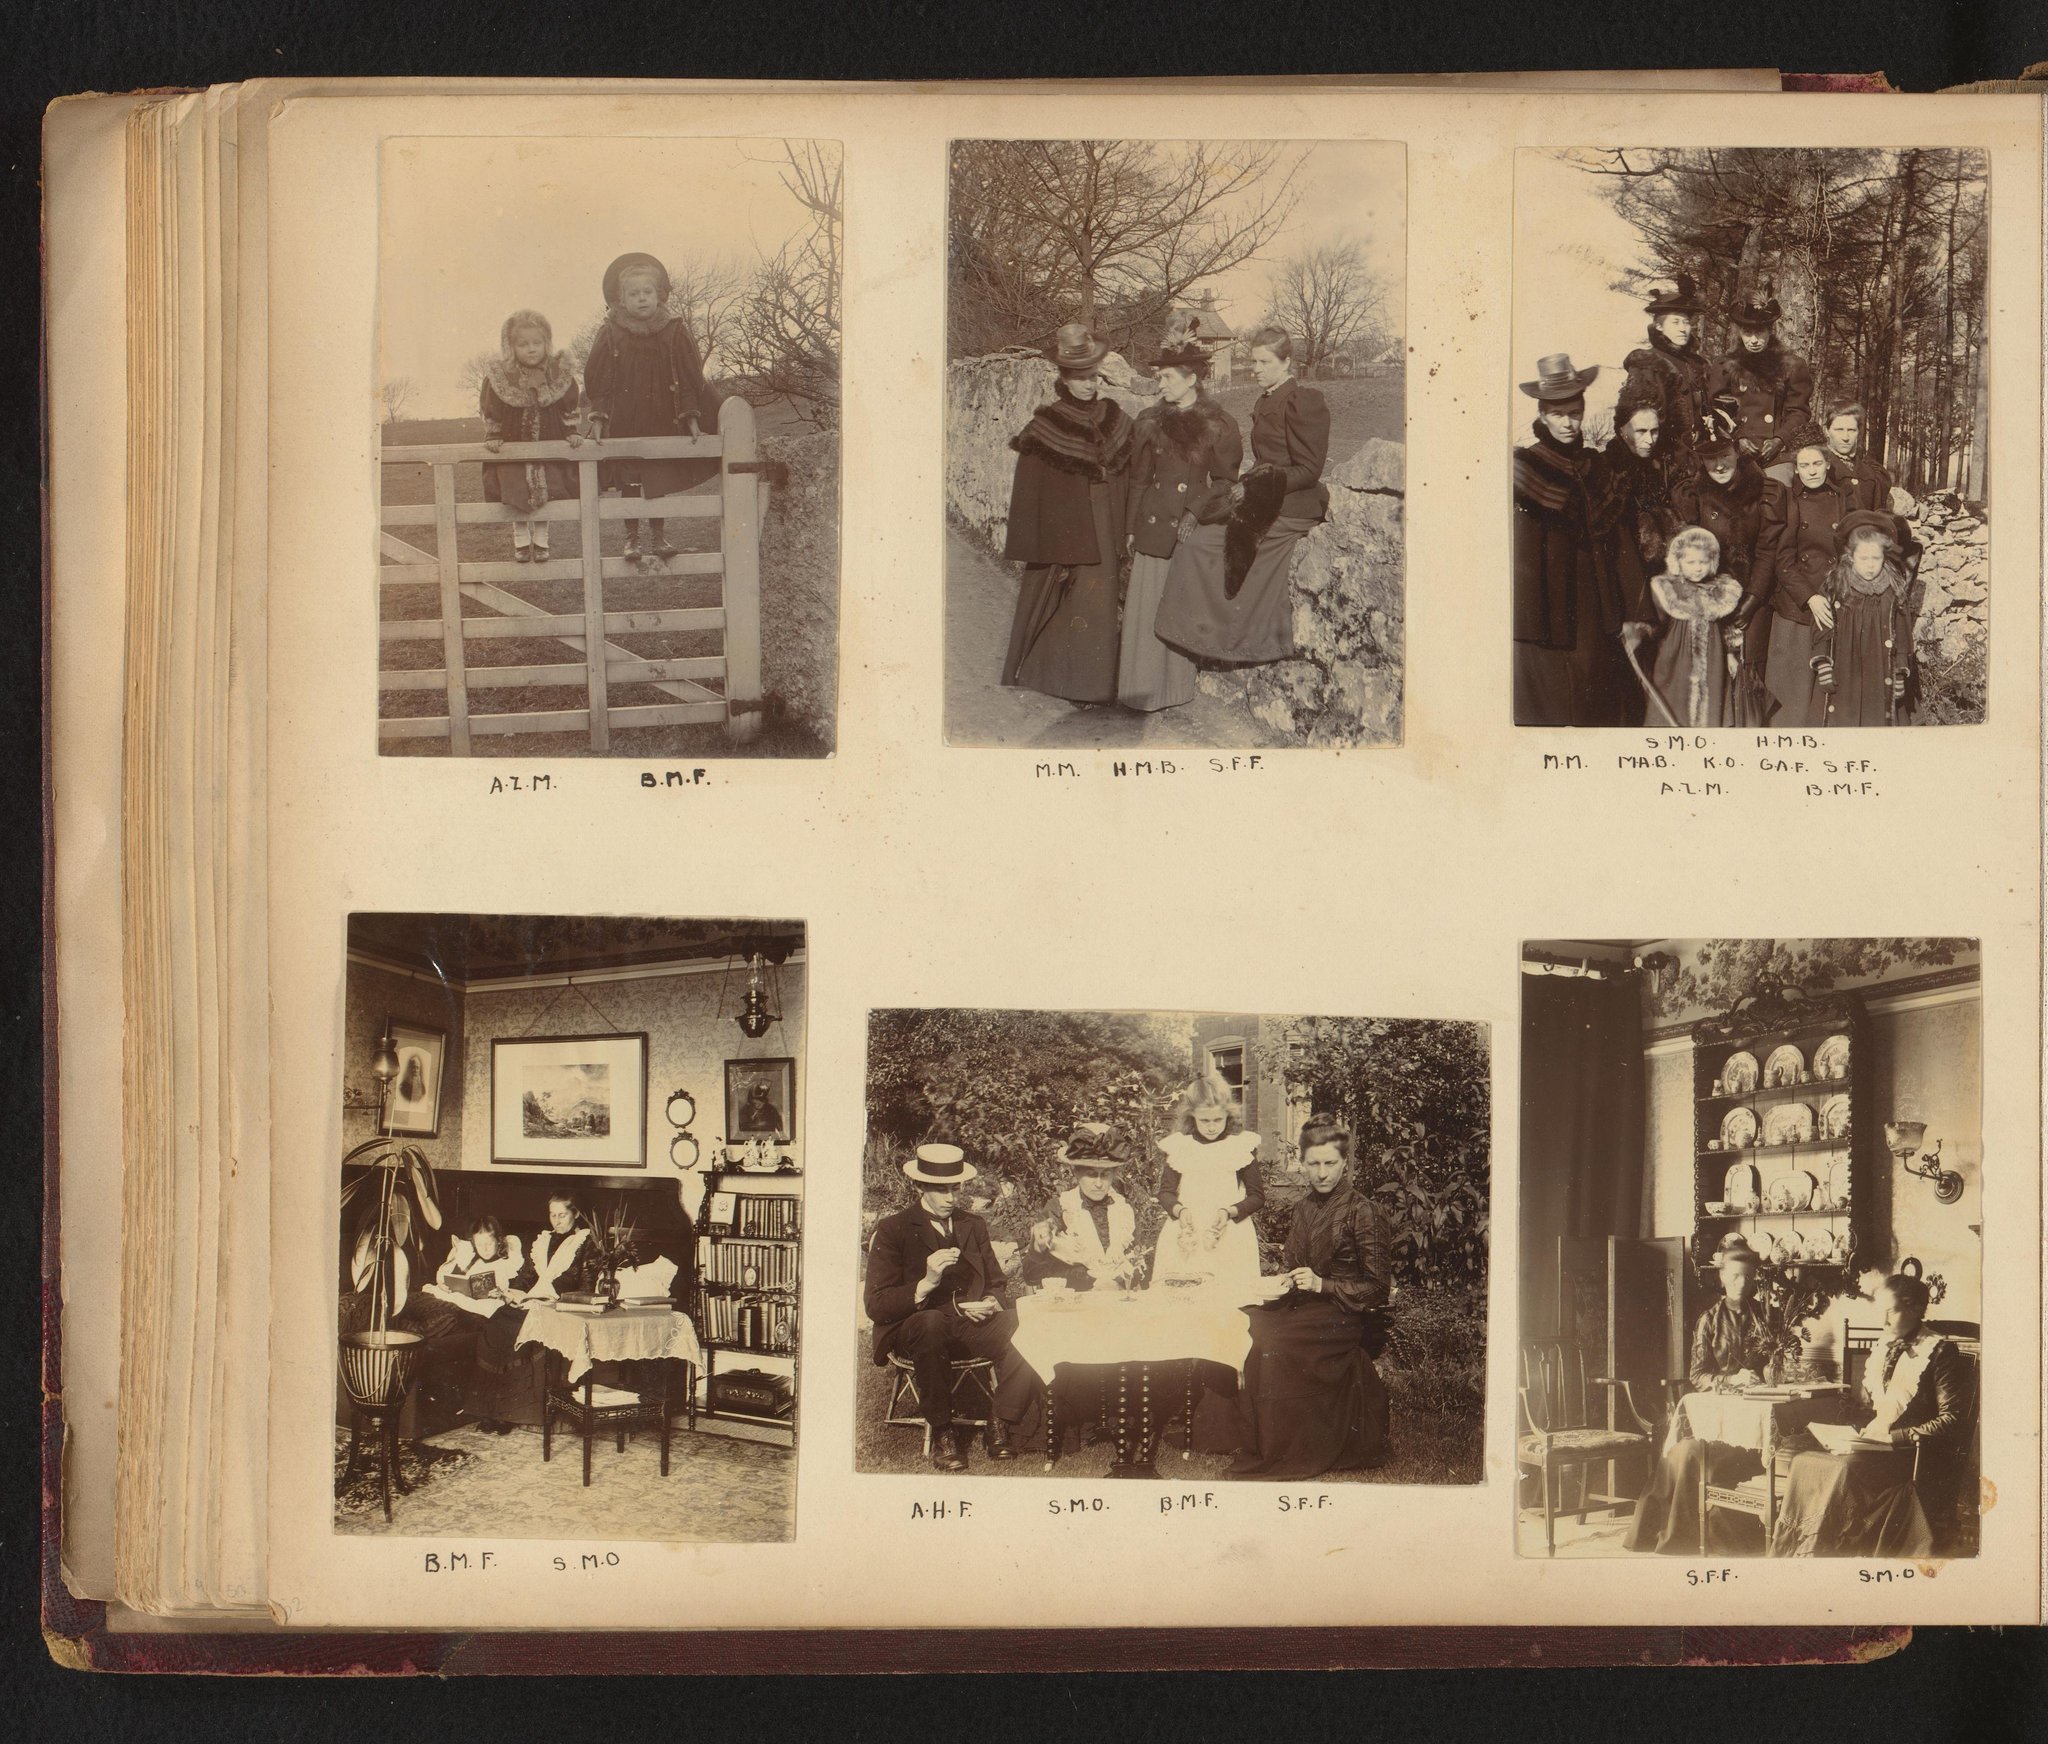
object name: photograph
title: Familieportretten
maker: Anonymous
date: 1890-1898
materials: photographic support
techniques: gelatin silver print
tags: adult woman, garden, adult man, child, family, relationship, descent, interior of the house, anonymous historical persons portrayed in a group, in a group-portrait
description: Onder de foto's staan de initialen van de geportretteerden. Deze pagina maakt deel uit van een album.